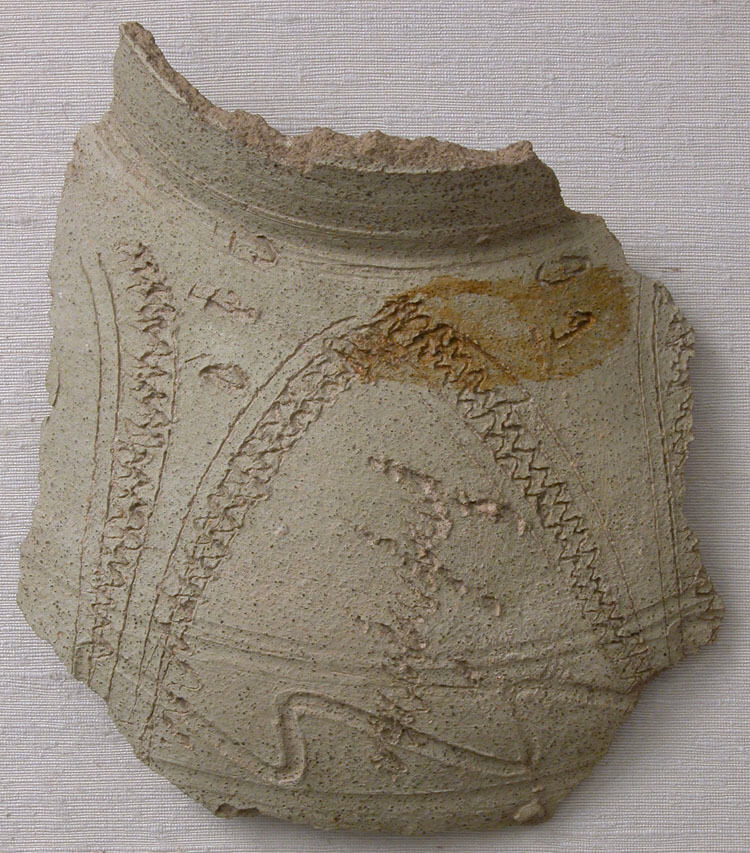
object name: fragment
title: Ceramic Fragment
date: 801-1000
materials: earthenware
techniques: incising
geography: saudi arabia